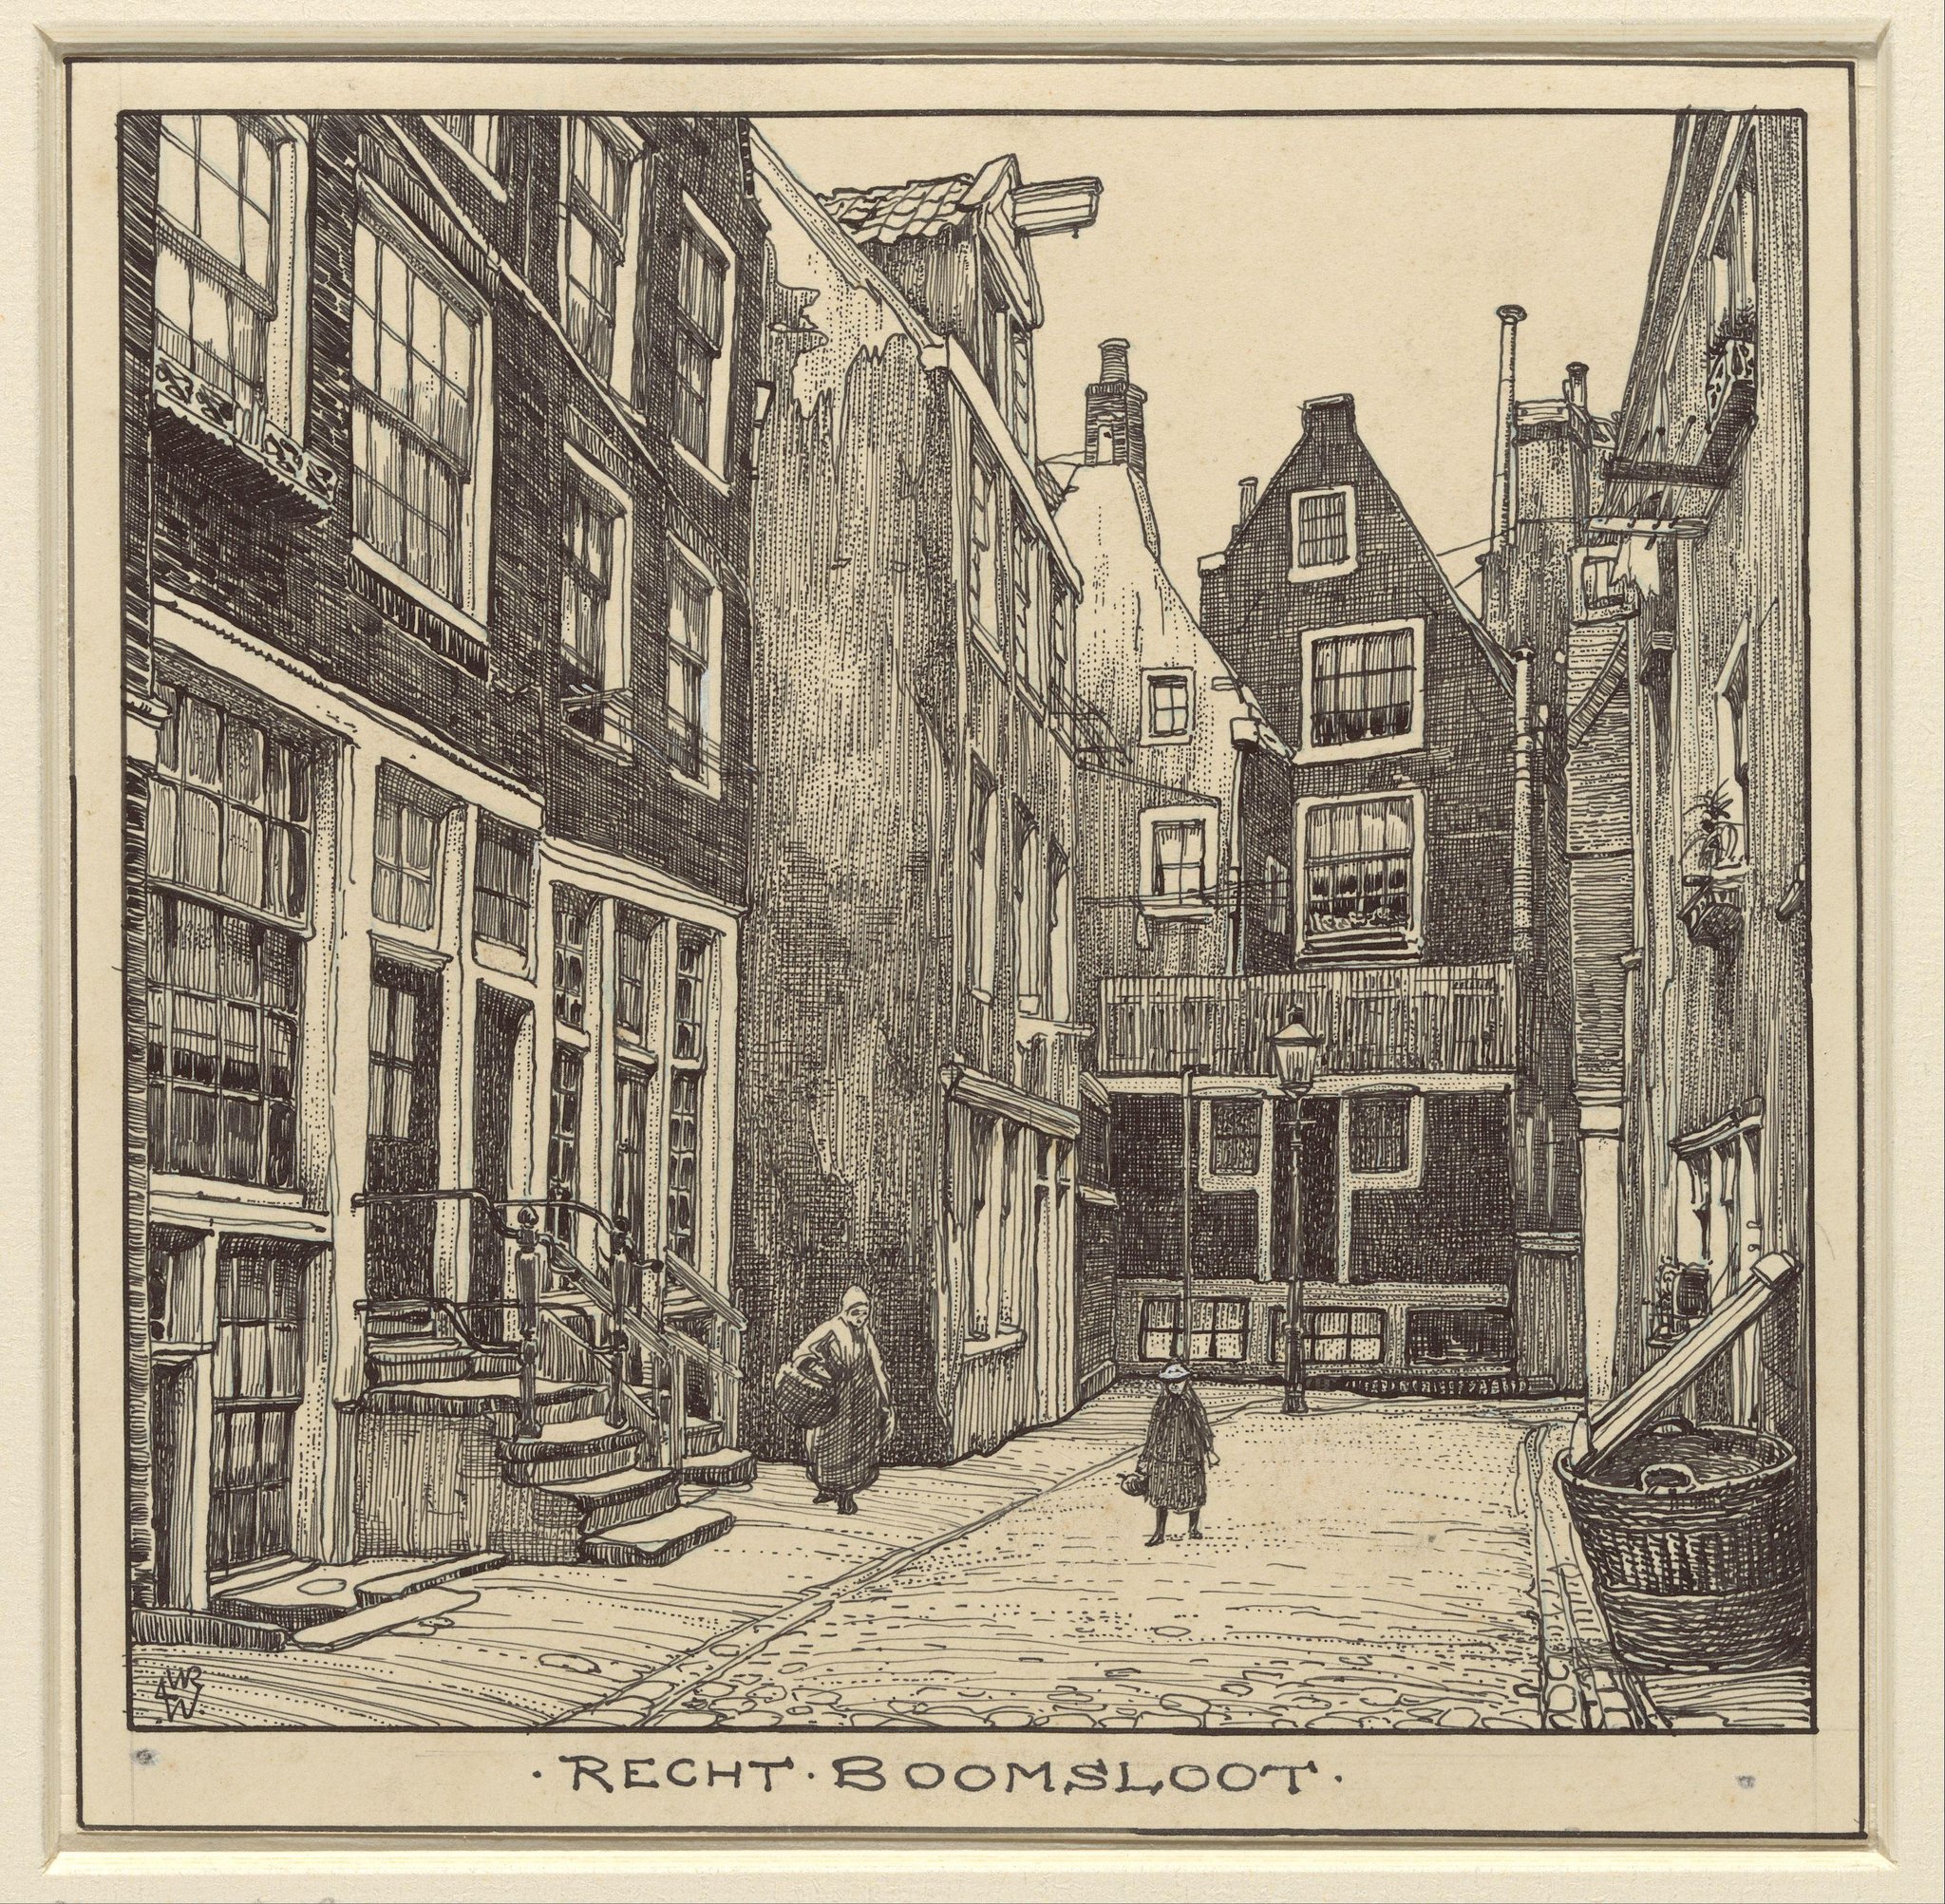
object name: drawing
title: Rechtboomsloot te Amsterdam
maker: willem wenckebach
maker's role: designer, draughtsman, painter, print maker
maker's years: 1860-1937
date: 1870-1926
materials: paint, ink, paper, pencil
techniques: pen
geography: amsterdam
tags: street